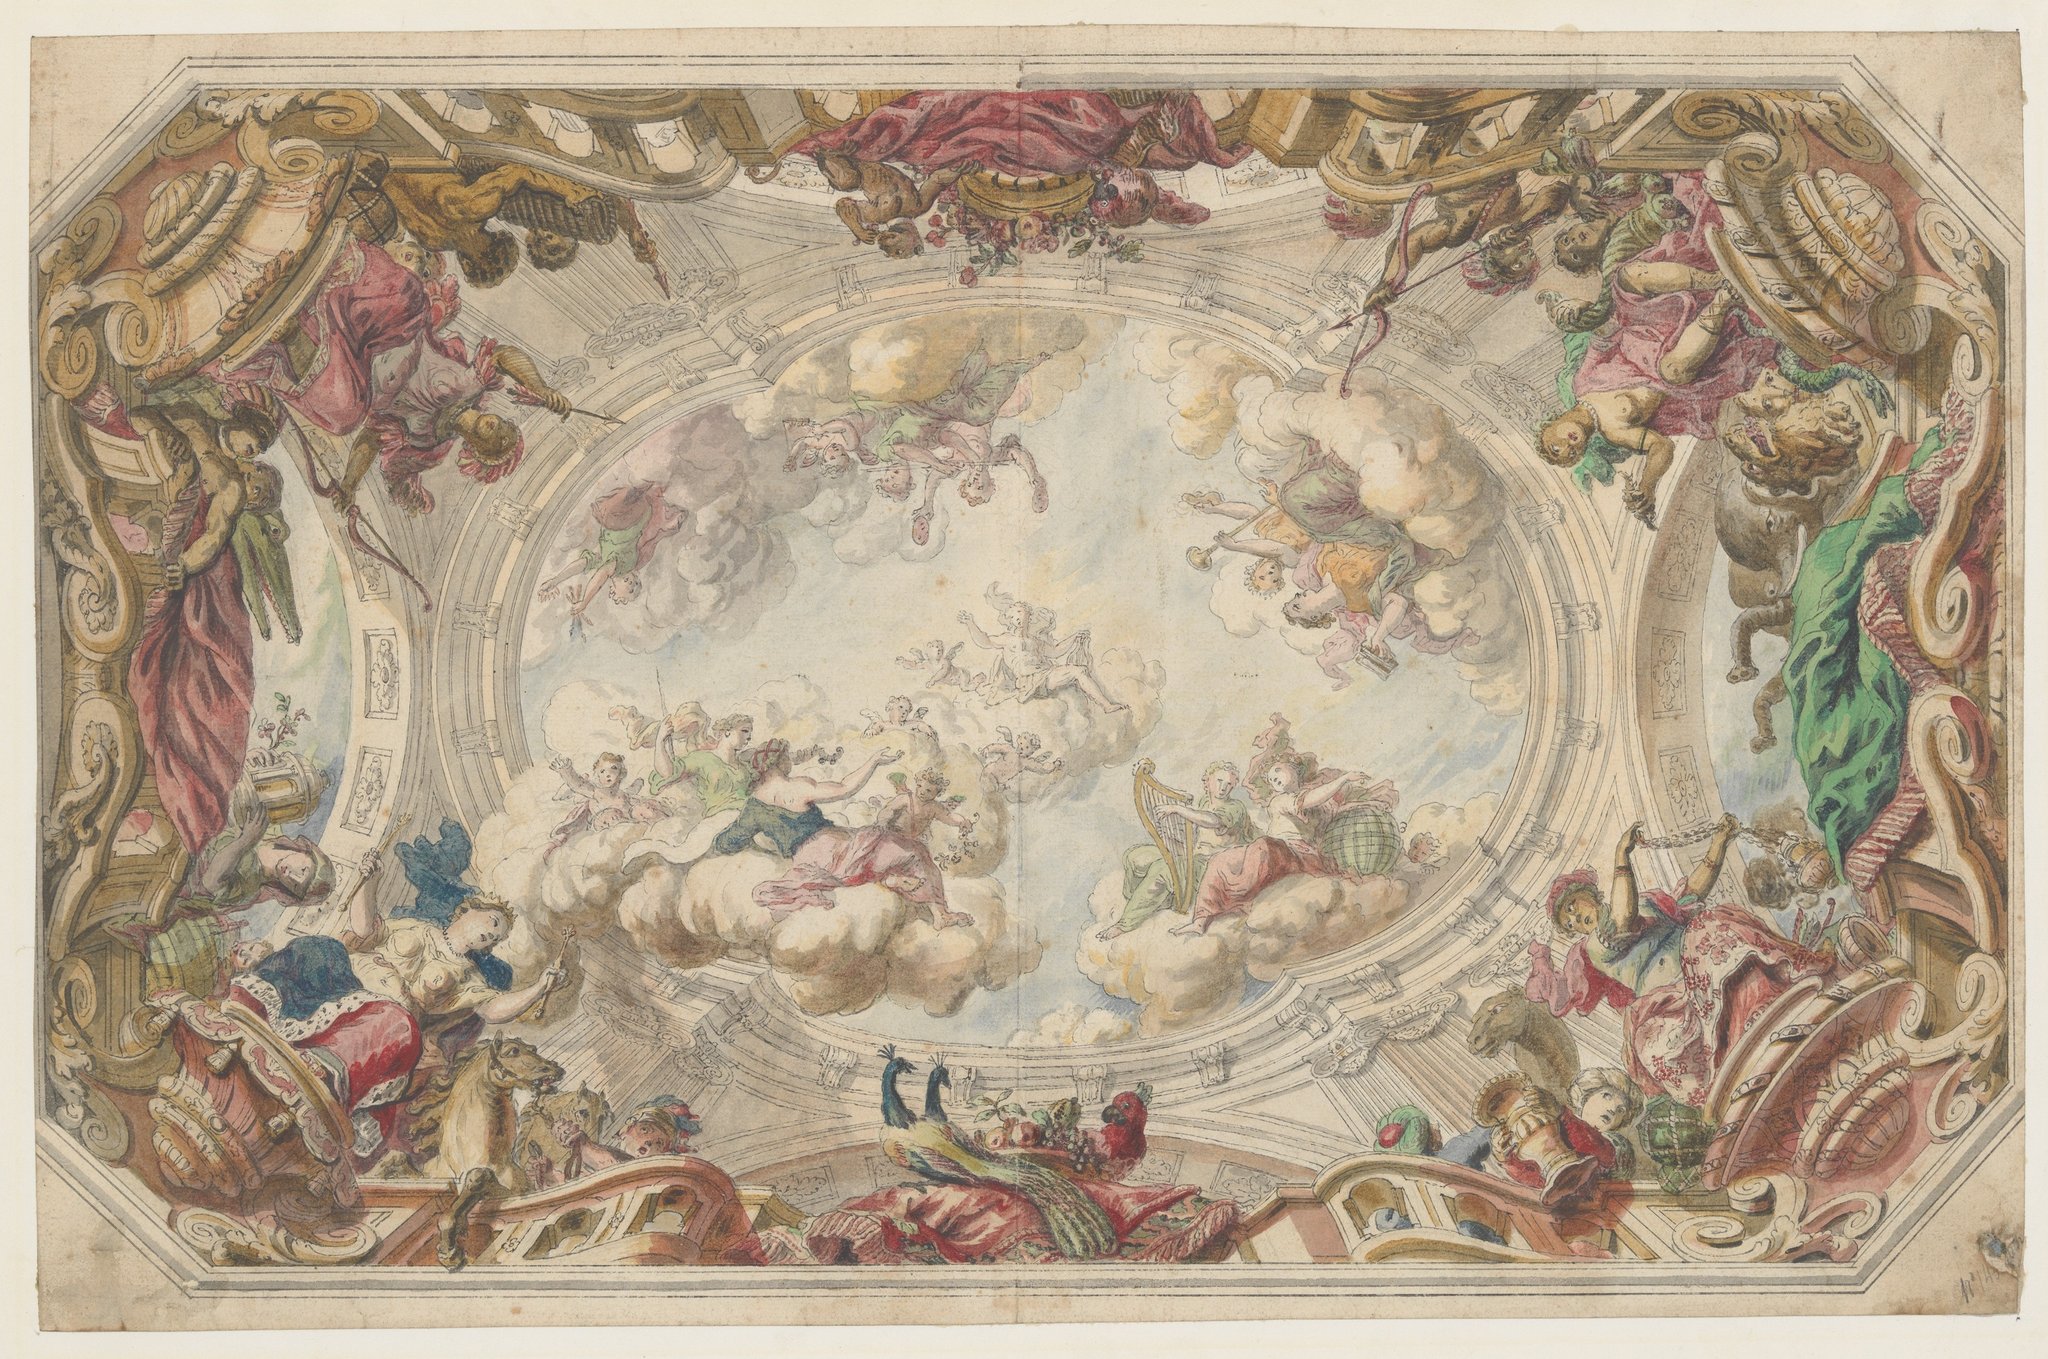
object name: drawing collection ornament architecture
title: Design for a Ceiling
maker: daniel marot the elder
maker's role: artist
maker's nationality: french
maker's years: 1661-1752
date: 1712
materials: ink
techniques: brush, pen, wash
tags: musical instruments,women,peacocks,ceilings